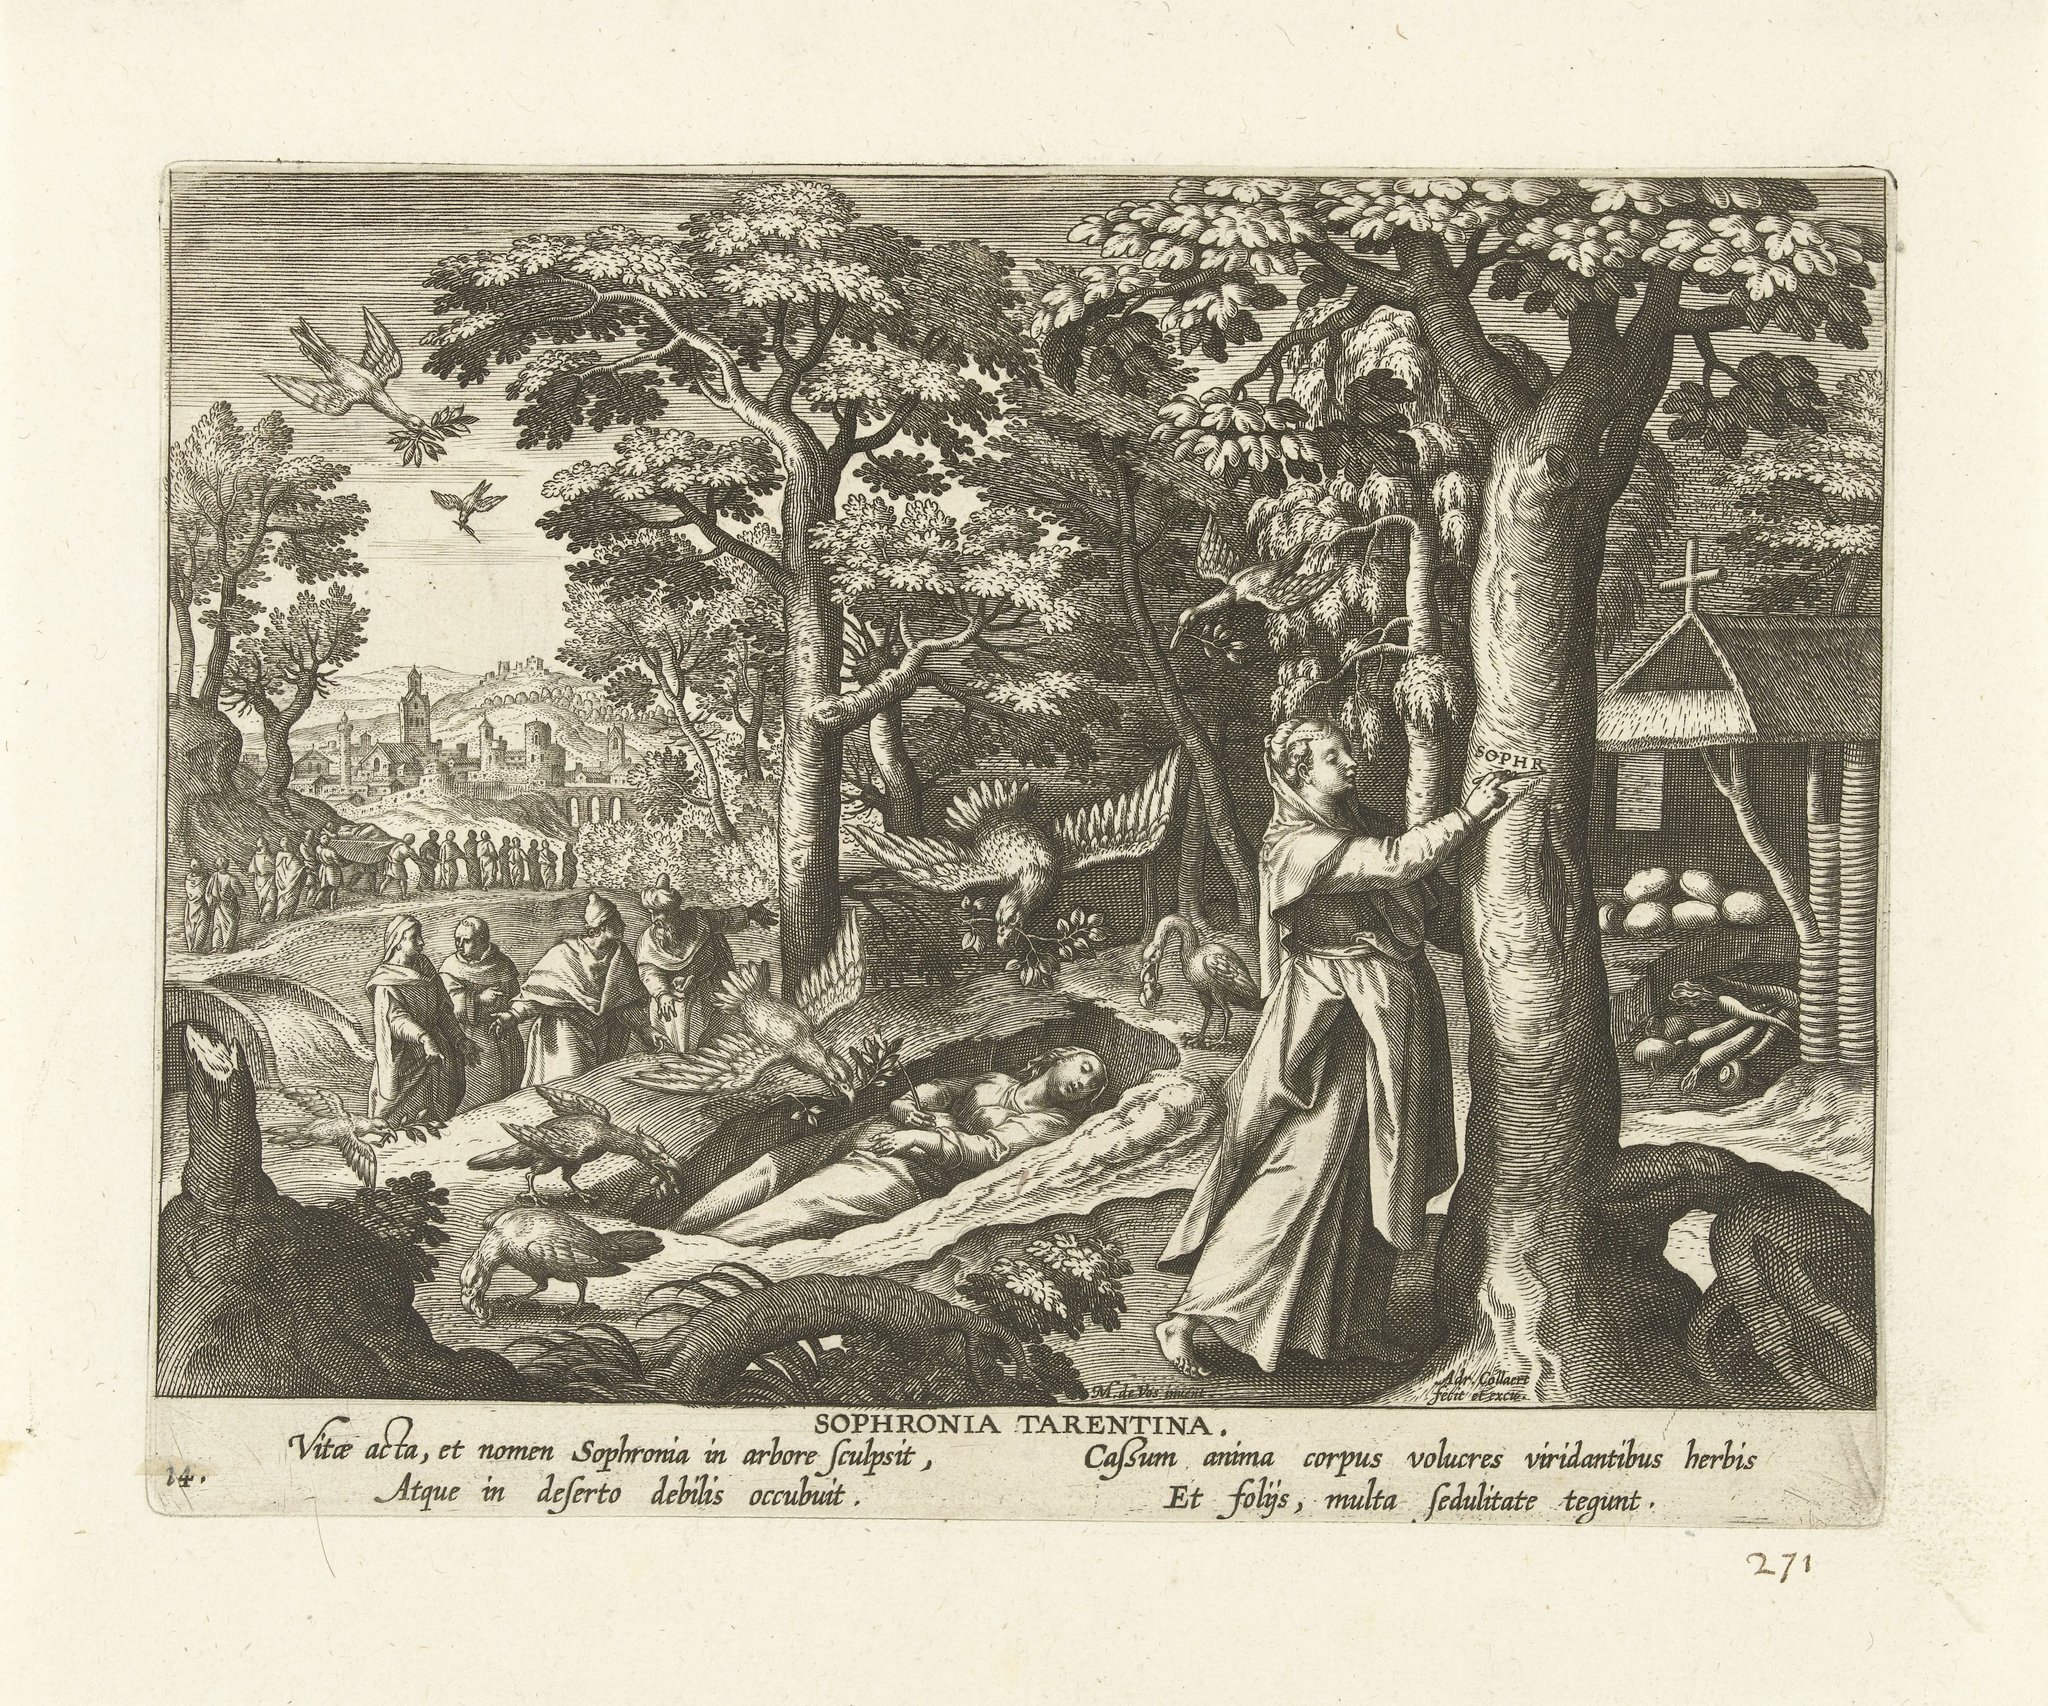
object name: print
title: Vrouwelijke kluizenaars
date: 1570-1618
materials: paper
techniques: engraving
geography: antwerp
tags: birds, anchorite, hermit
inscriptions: collector's mark: Lugt 2228, number: ‘271’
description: De locale Italiaanse heilige Sofronia van Taranto in de wildernis. Ze schrijft haar naam in een boom. In het midden van de prent wordt ze na haar dood bedekt met bladeren door vogels van het woud. Zo wordt ze ontdekt door voorbijgangers, die haar lijk in processie terug naar Taranto brengen. De prent heeft een Latijns onderschrift en maakt deel uit van een serie uit vierentwintig prenten met als onderwerp vrouwelijke kluizenaars.